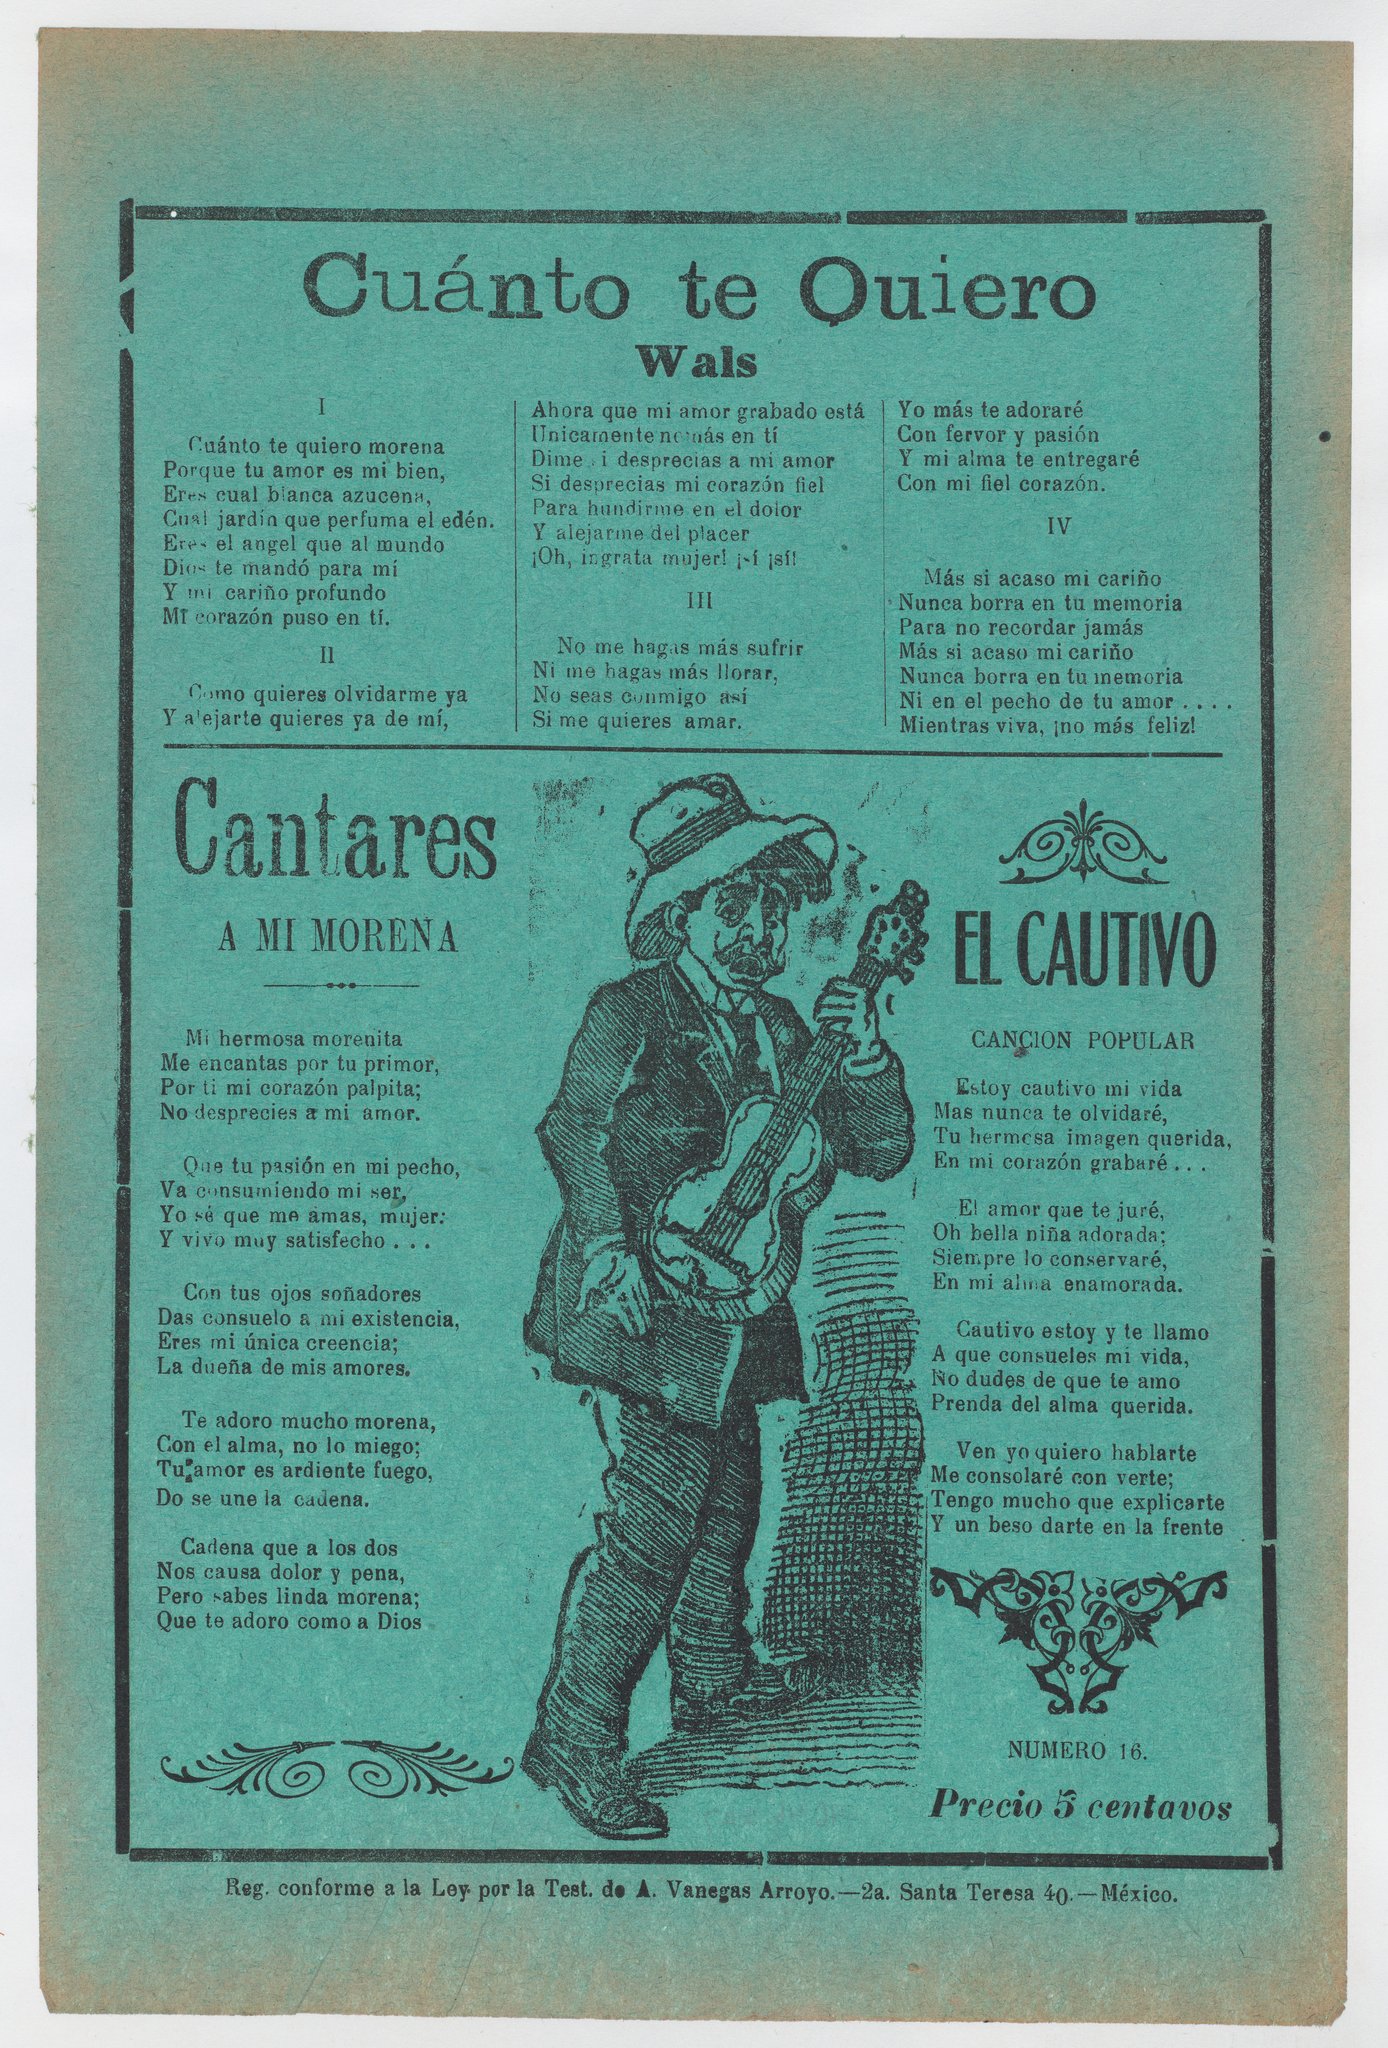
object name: print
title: Broadsheet with three love songs; a man singing and playing the guitar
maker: josé guadalupe posada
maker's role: artist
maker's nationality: mexican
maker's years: 1852-1913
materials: paper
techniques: letterpress, lithography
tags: men,guitars